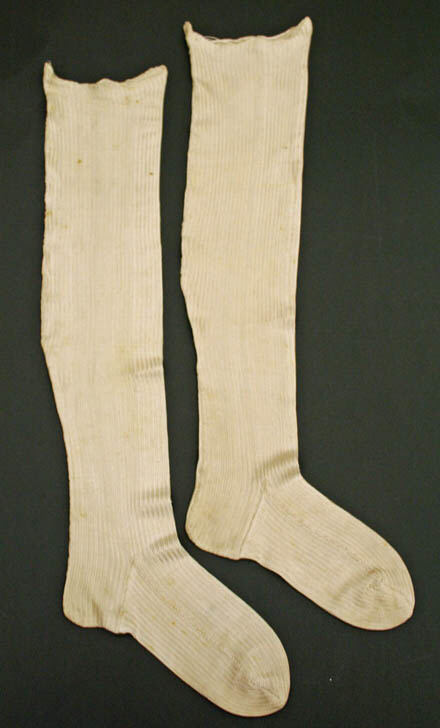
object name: wedding stocking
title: Wedding stockings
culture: american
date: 1842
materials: silk